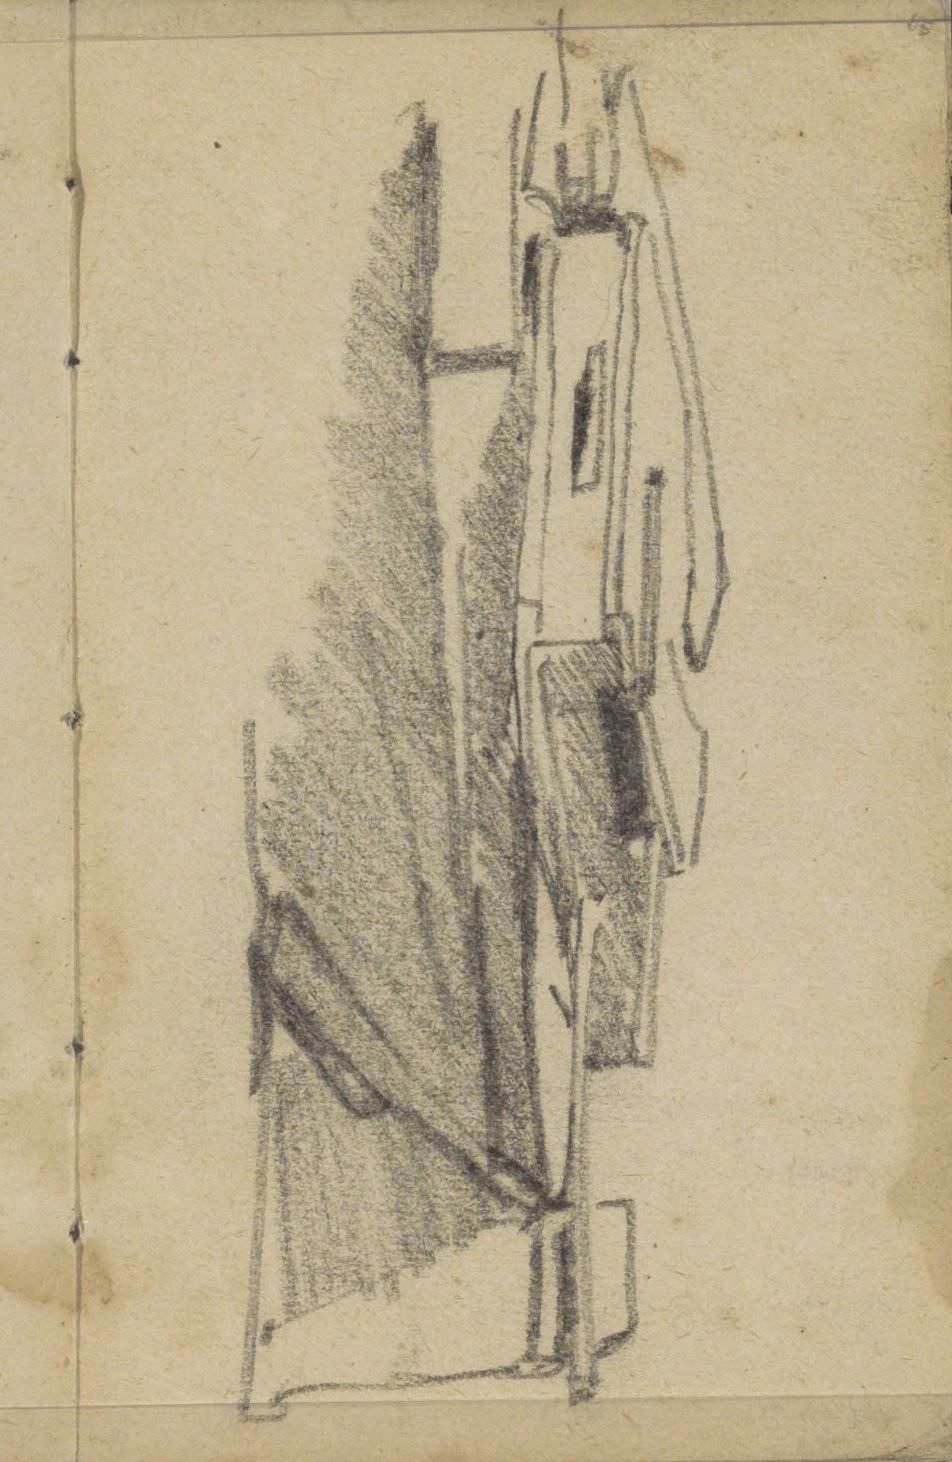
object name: sketchbook leaf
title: Boot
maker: george hendrik breitner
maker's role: draughtsman, painter, print maker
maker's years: 1857-1923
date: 1881-1883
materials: chalk, paper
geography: south holland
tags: ships (in general)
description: Boot. Pagina 65 uit een schetsboek met 43 bladen.